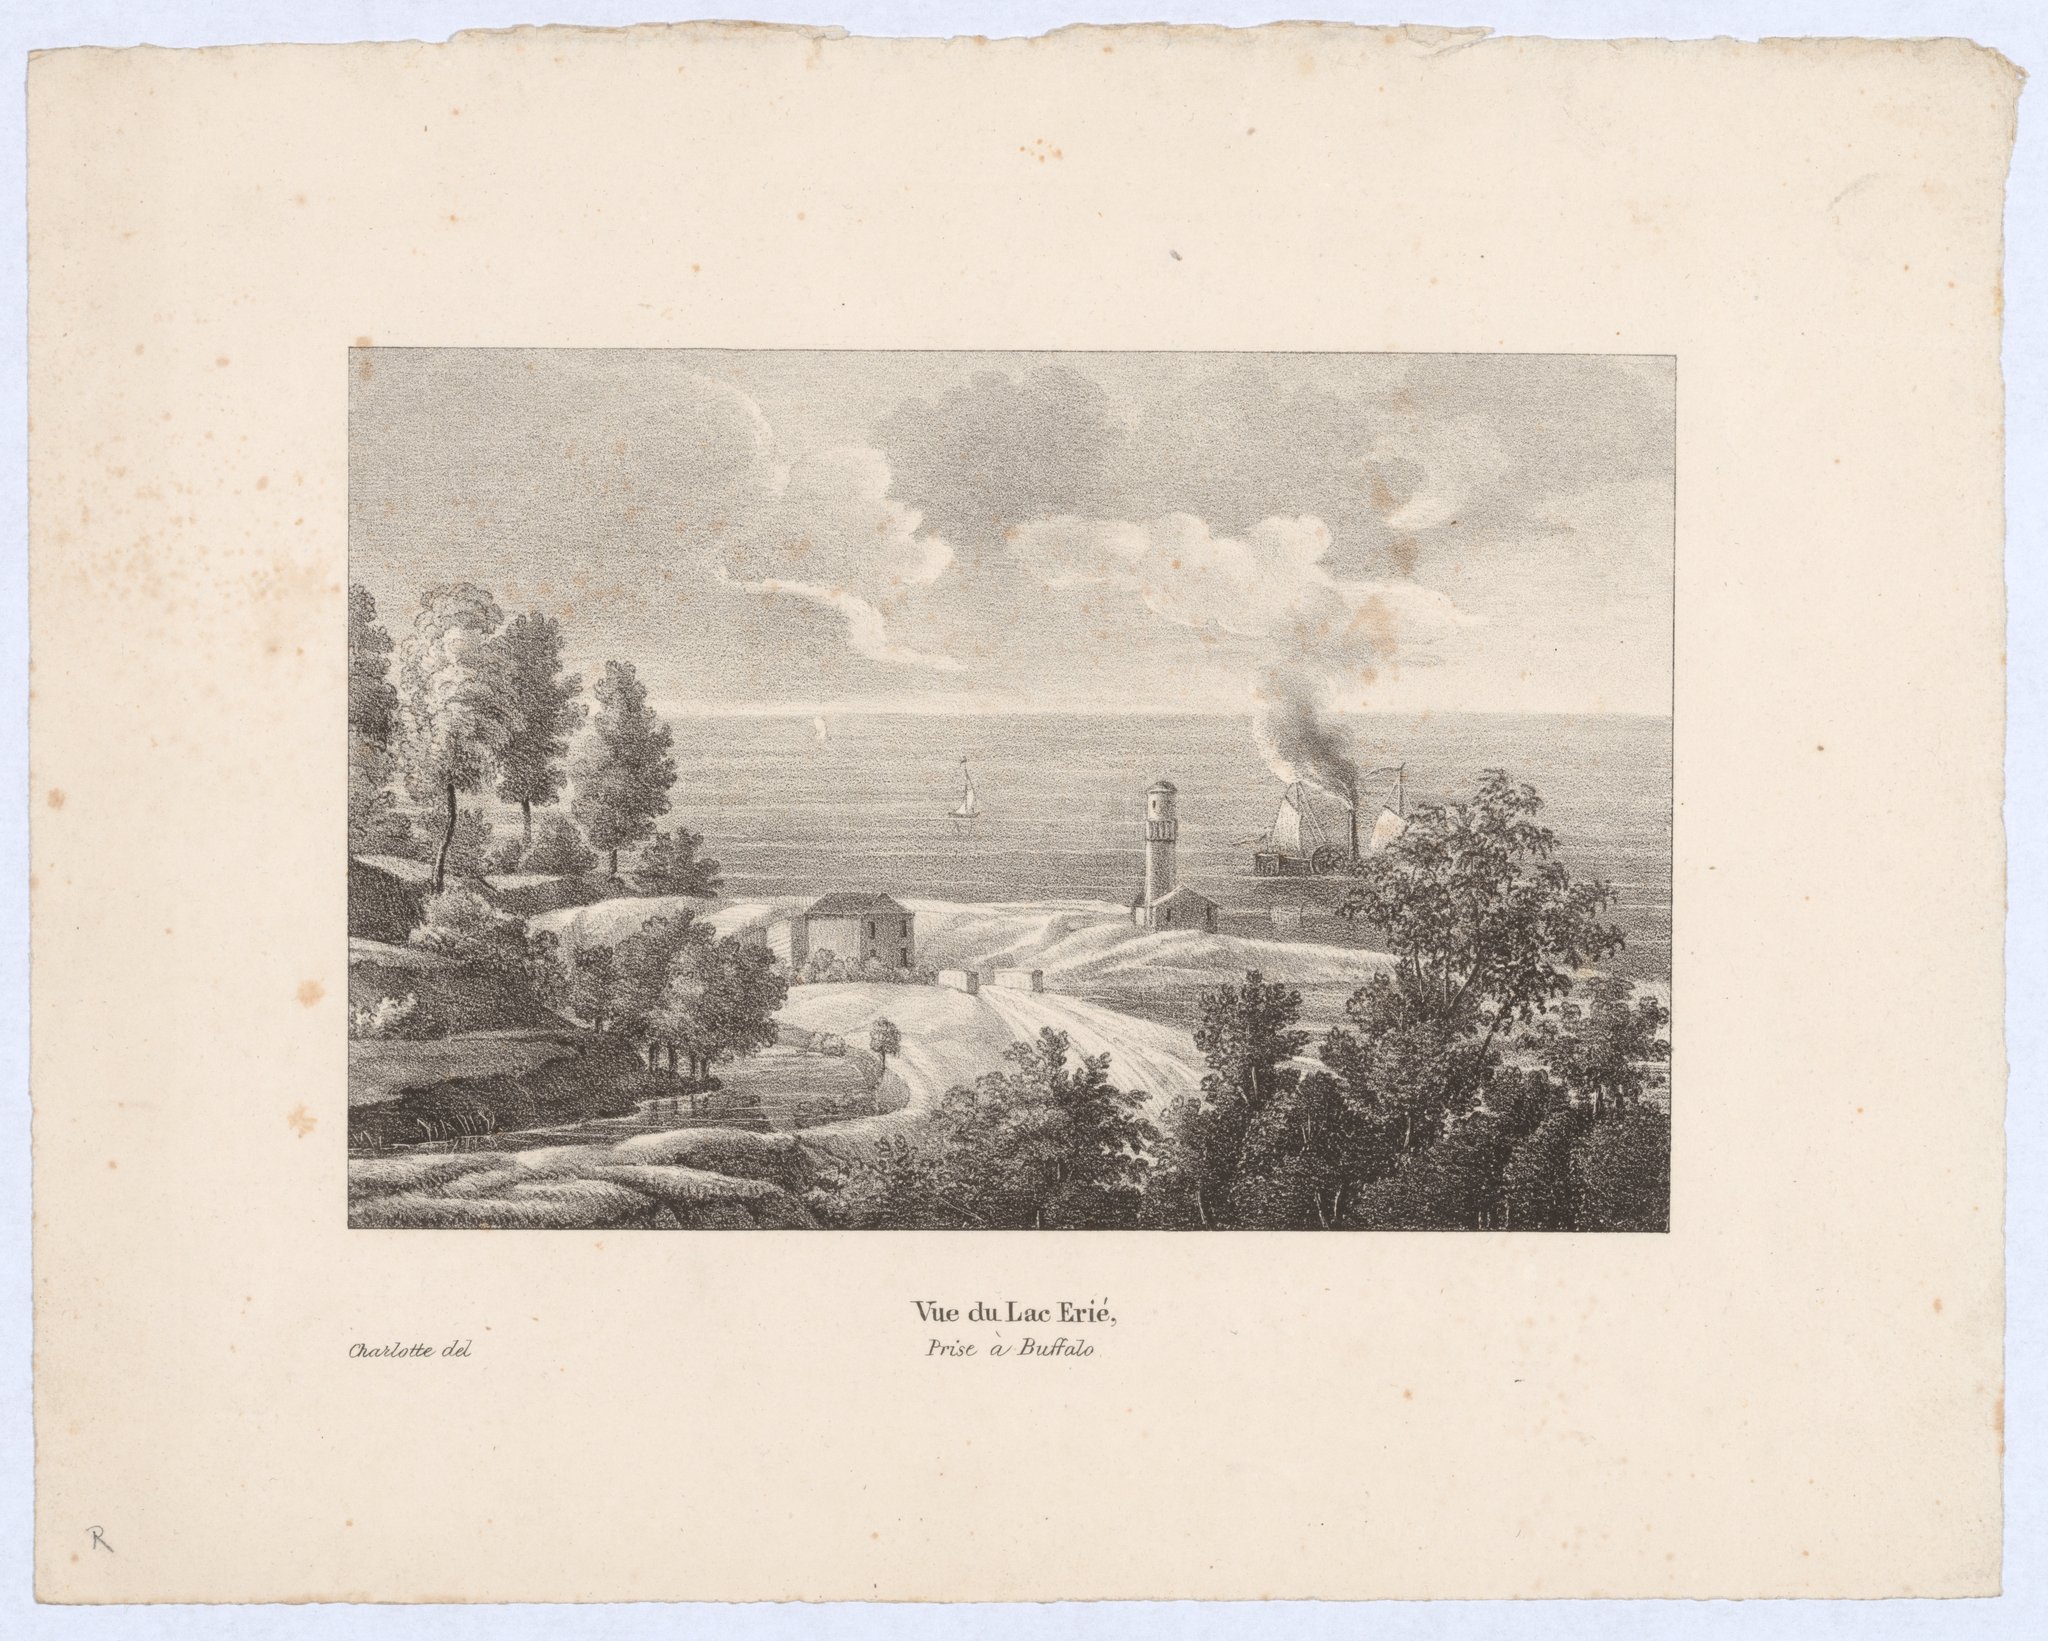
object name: print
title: Vue du Lac Erié, Prise à Buffalo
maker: charlotte bonaparte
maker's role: artist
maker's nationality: french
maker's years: 1802-1839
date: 1824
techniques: lithograph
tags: lakes,landscapes